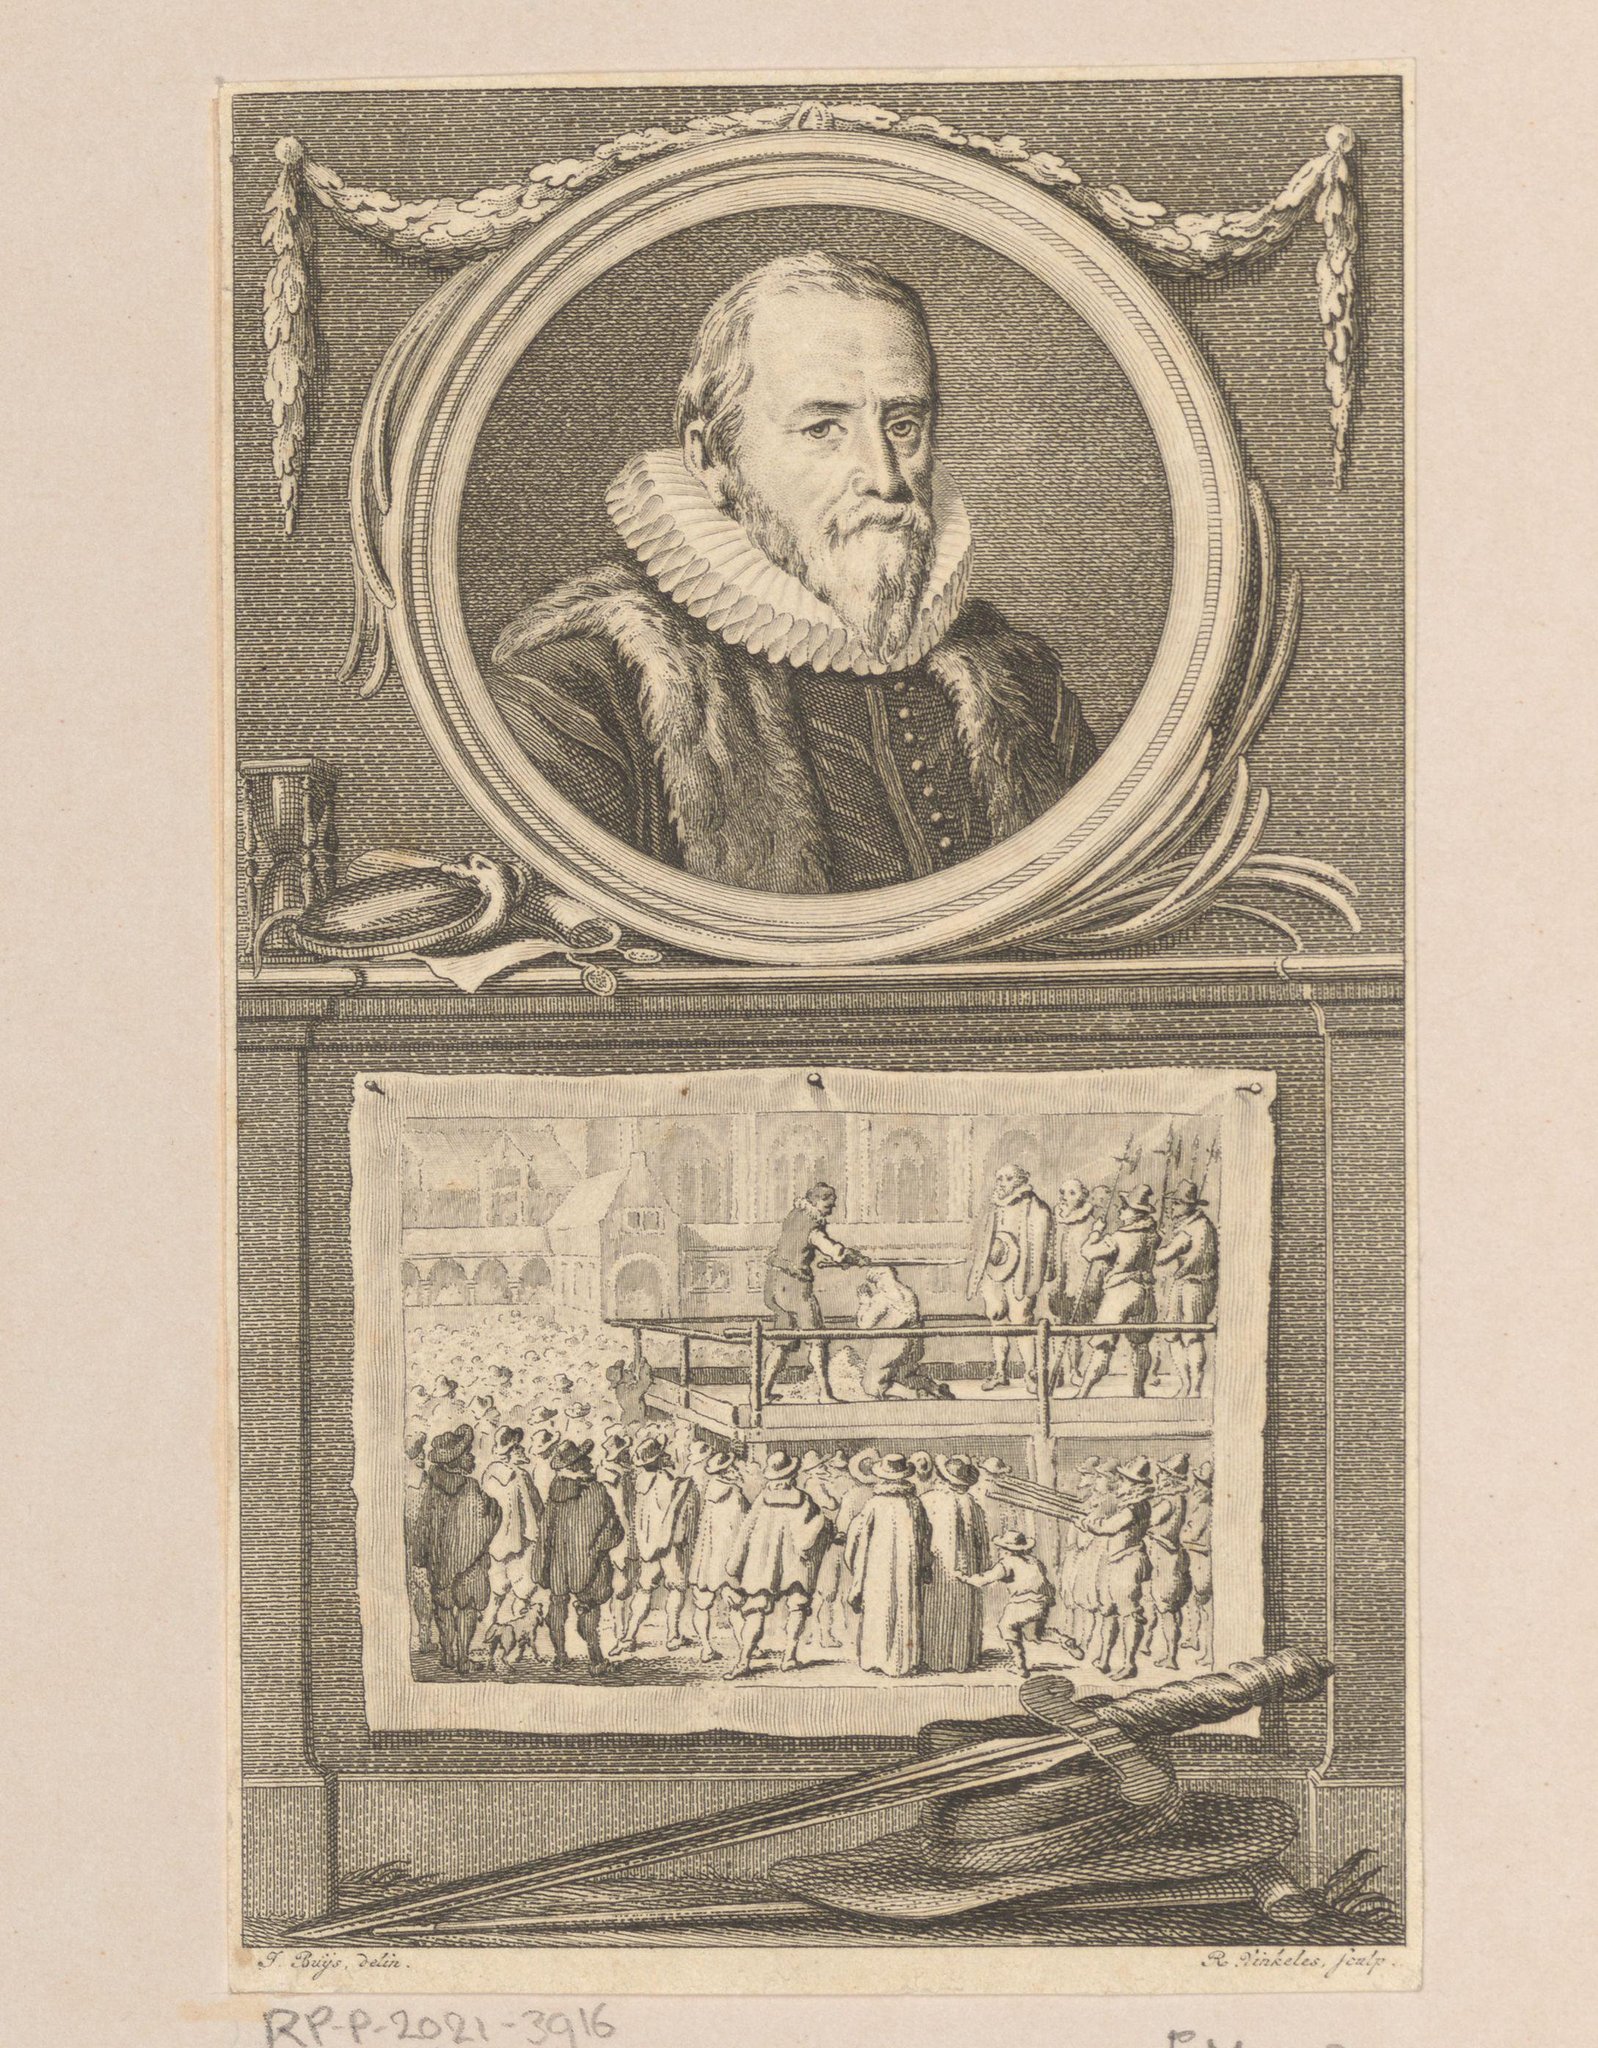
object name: print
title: Portret van Johan van Oldenbarnevelt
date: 1751-1816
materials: paper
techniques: engraving, etching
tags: the hague, johan van oldenbarnevelt, violent death by sword (+ execution (by judicial verdict)), historical persons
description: Onder zijn portret een afbeelding van zijn executie op het schavot voor de Ridderzaal op het Haagse Binnenhof, opgeprikt vel papier. Op de voorgrond zijn hoed, wandelstok en het zwaard waarmee hij werd onthoofd.